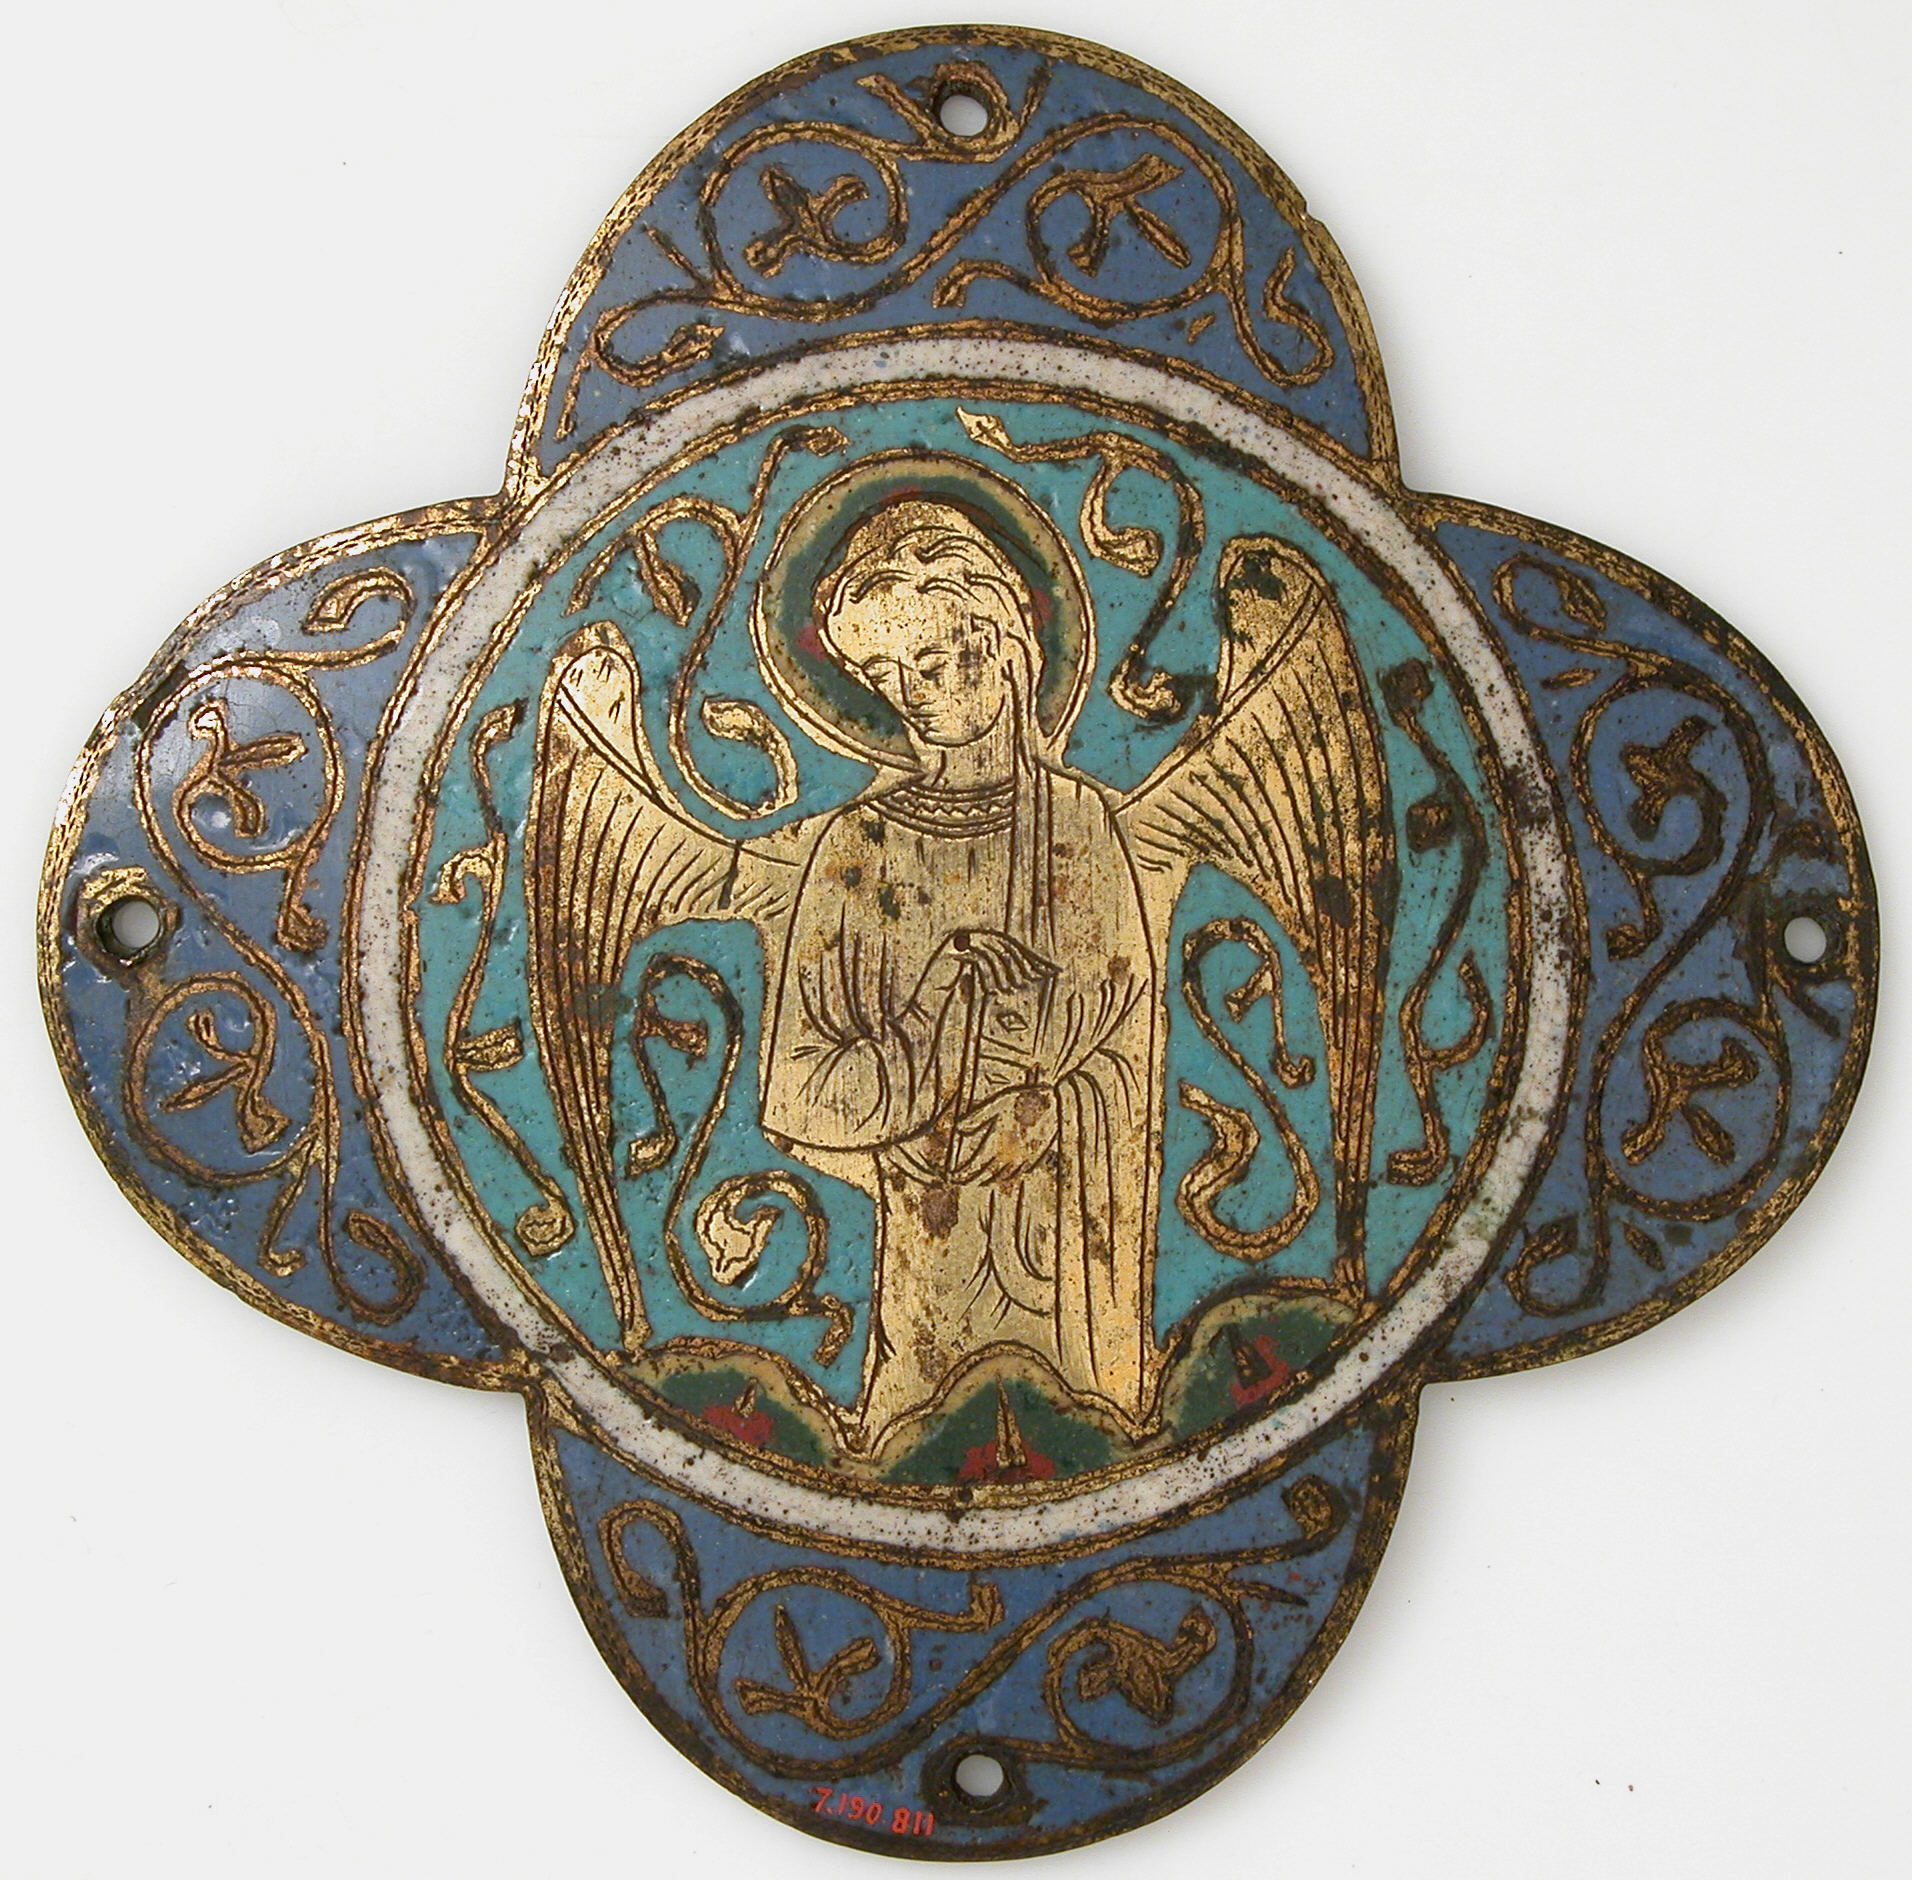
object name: plaque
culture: french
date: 1226-1250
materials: copper, enamel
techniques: enamel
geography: france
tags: angels